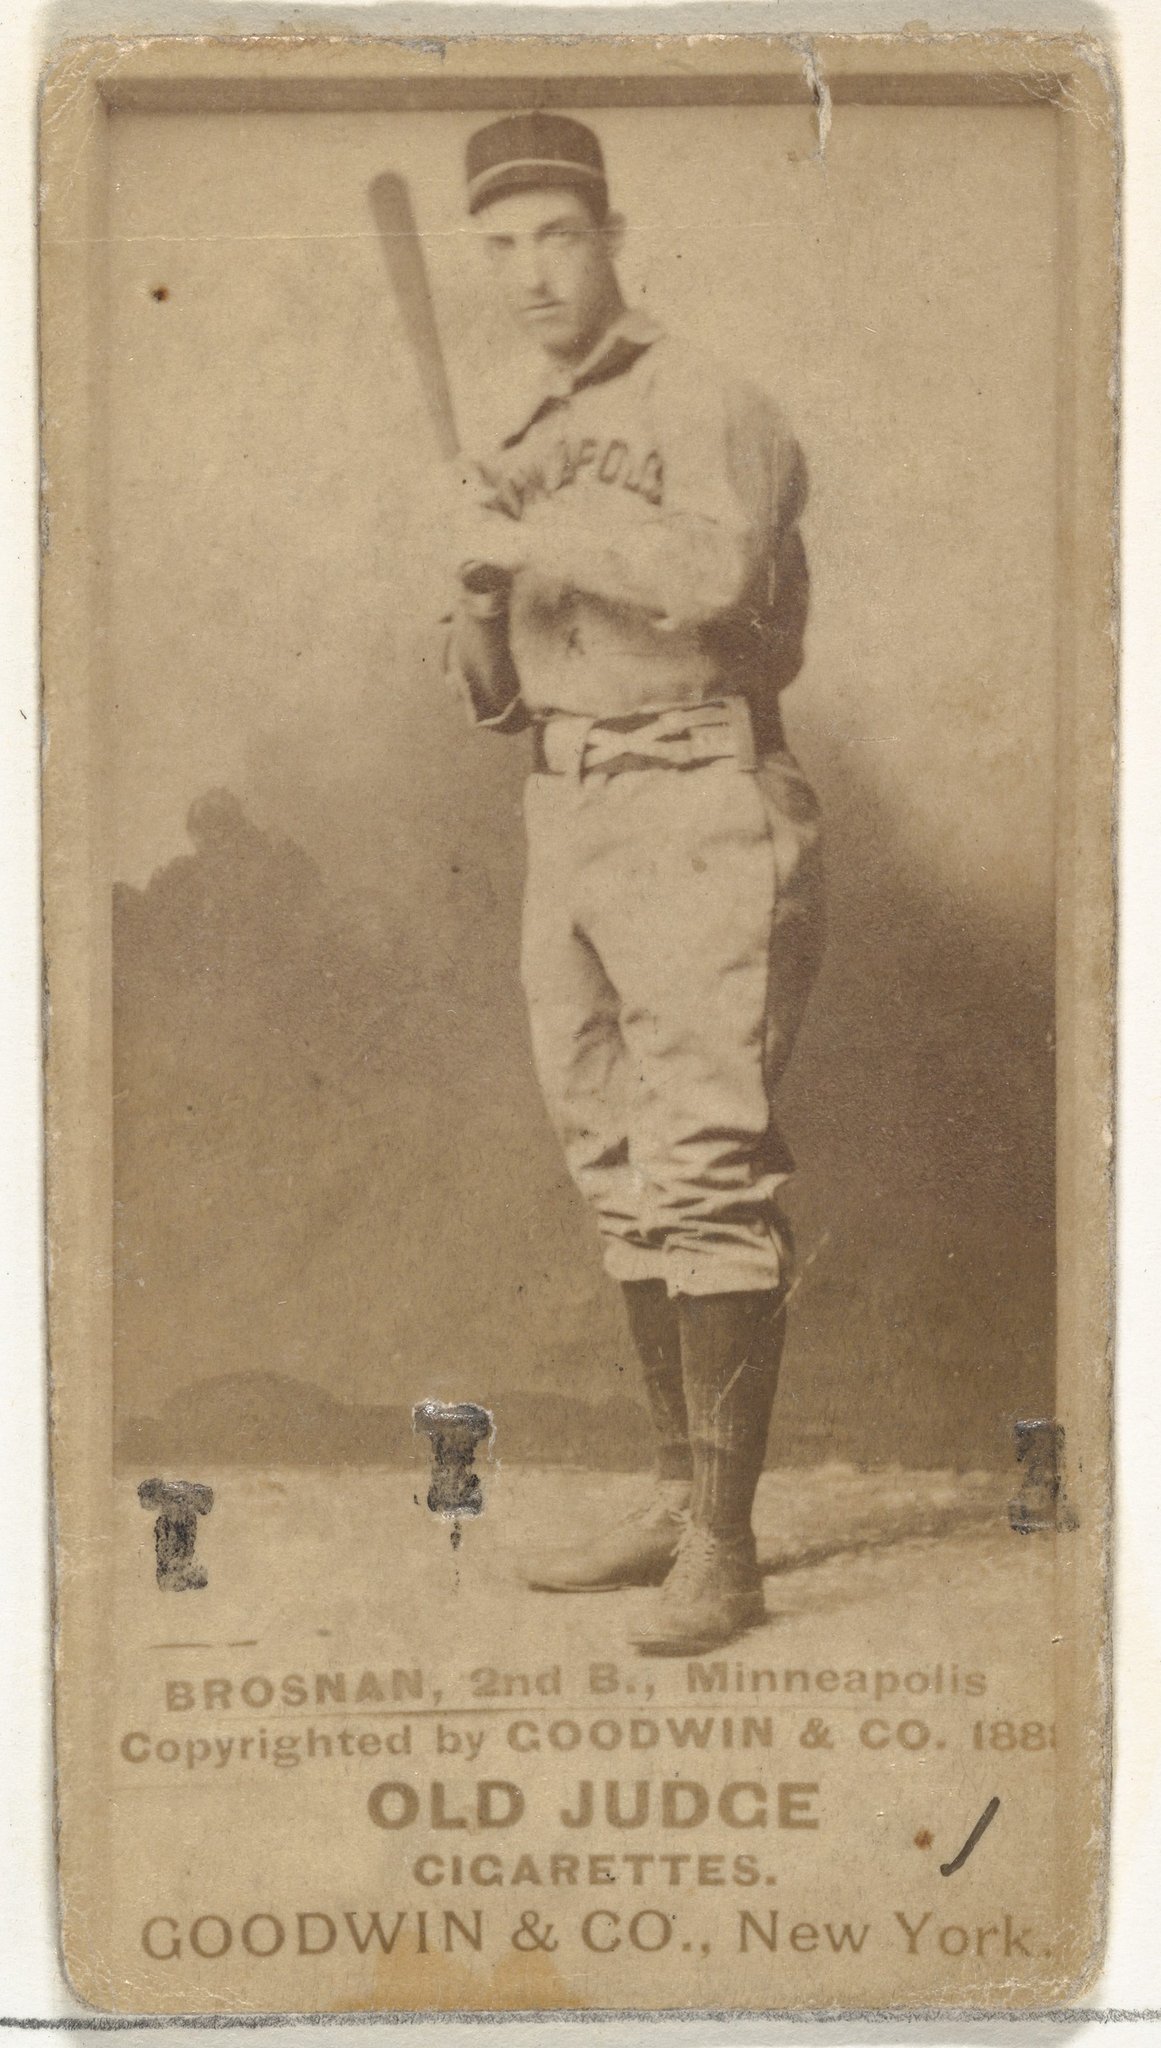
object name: baseball card, photograph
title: Timothy J. Brosnan, 2nd Base, Minneapolis, from the Old Judge series (N172) for Old Judge Cigarettes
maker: goodwin & company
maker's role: publisher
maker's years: 1850-1950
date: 1888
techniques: albumen silver print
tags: men,portraits,baseball,athletes